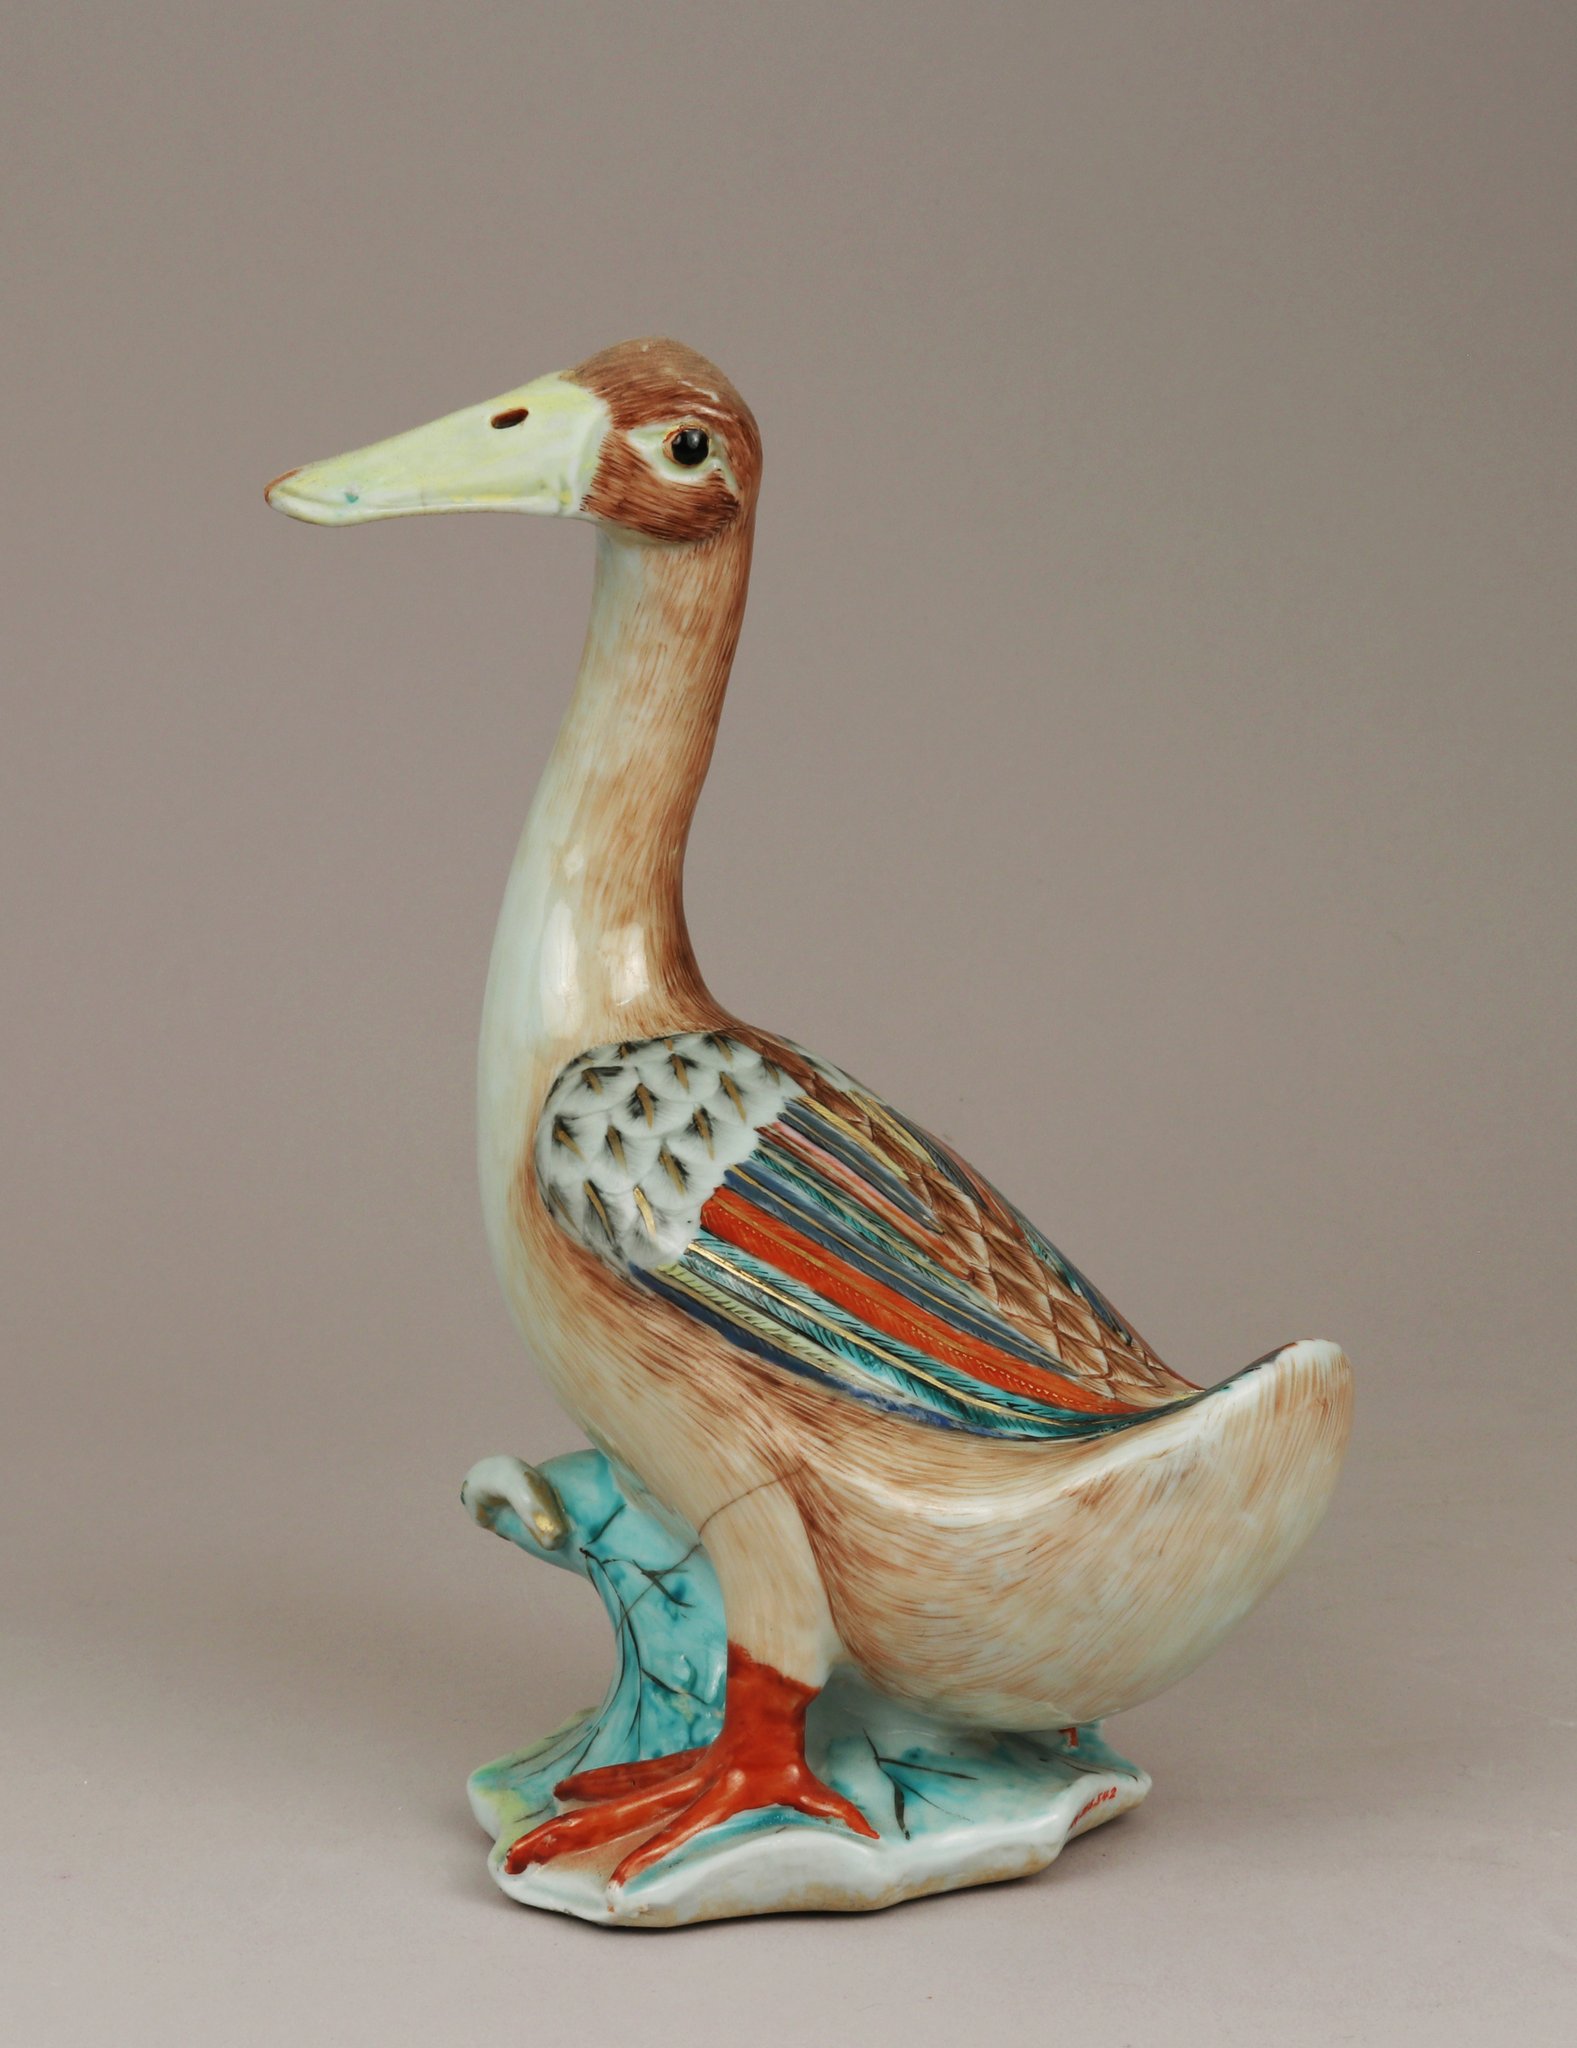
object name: figure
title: Duck (one of a pair)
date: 1760-1770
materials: hard paste porcelain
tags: ducks